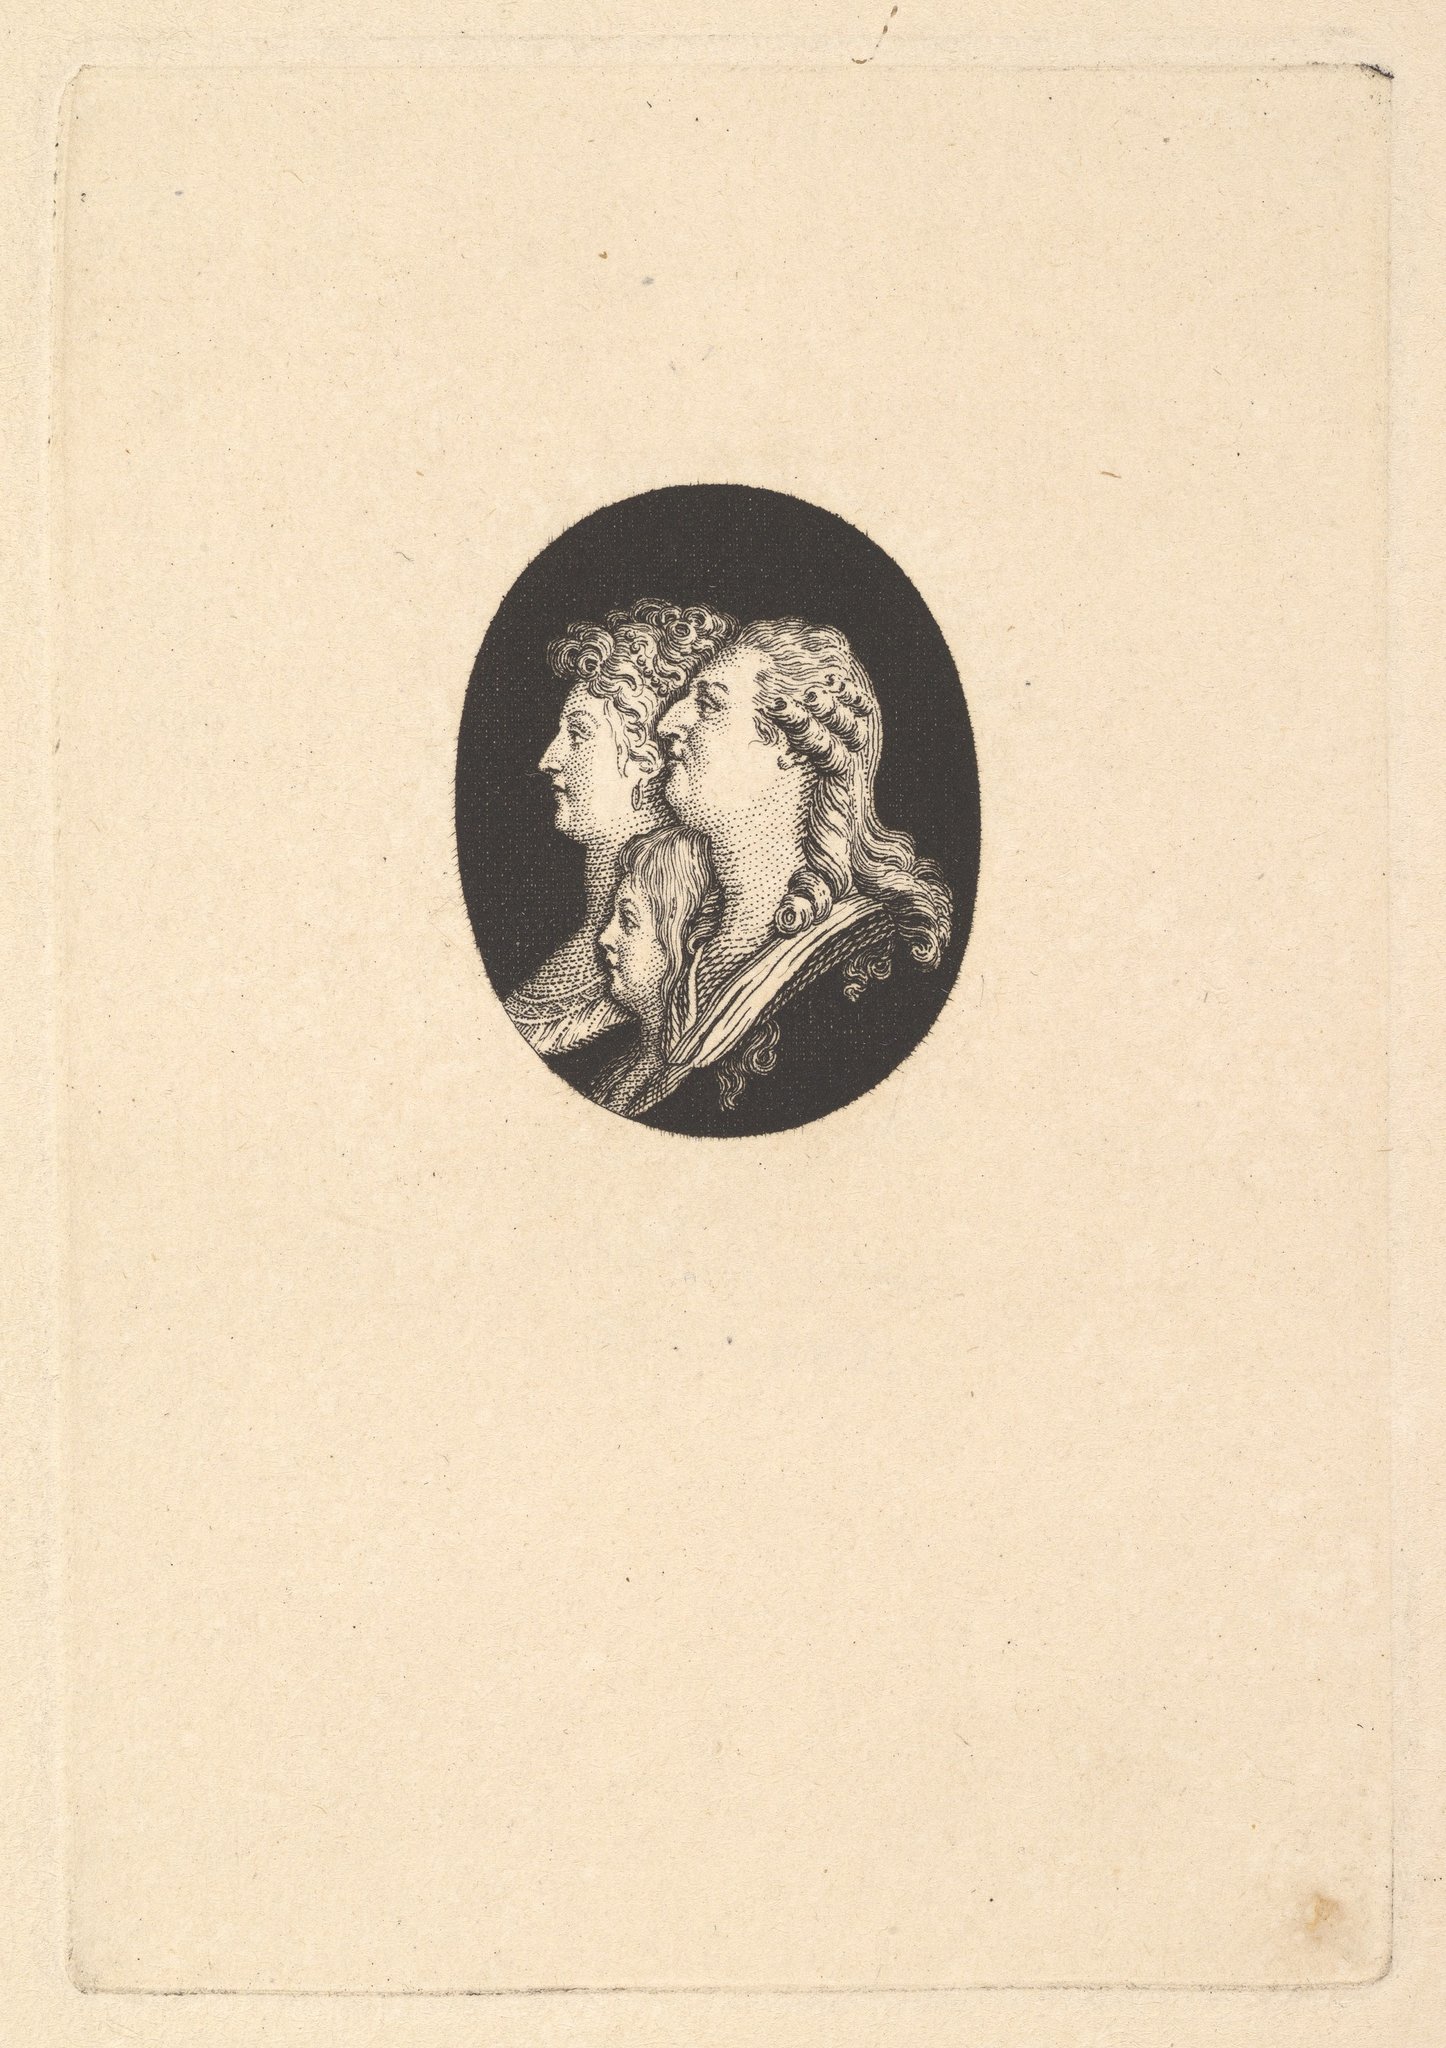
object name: print ornament architecture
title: Portrait of Louis XVI, Marie Antoinette and The Dauphin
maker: augustin de saint-aubin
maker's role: artist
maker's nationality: french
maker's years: 1736-1807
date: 1791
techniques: engraving, etching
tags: kings,princes,queens,profiles